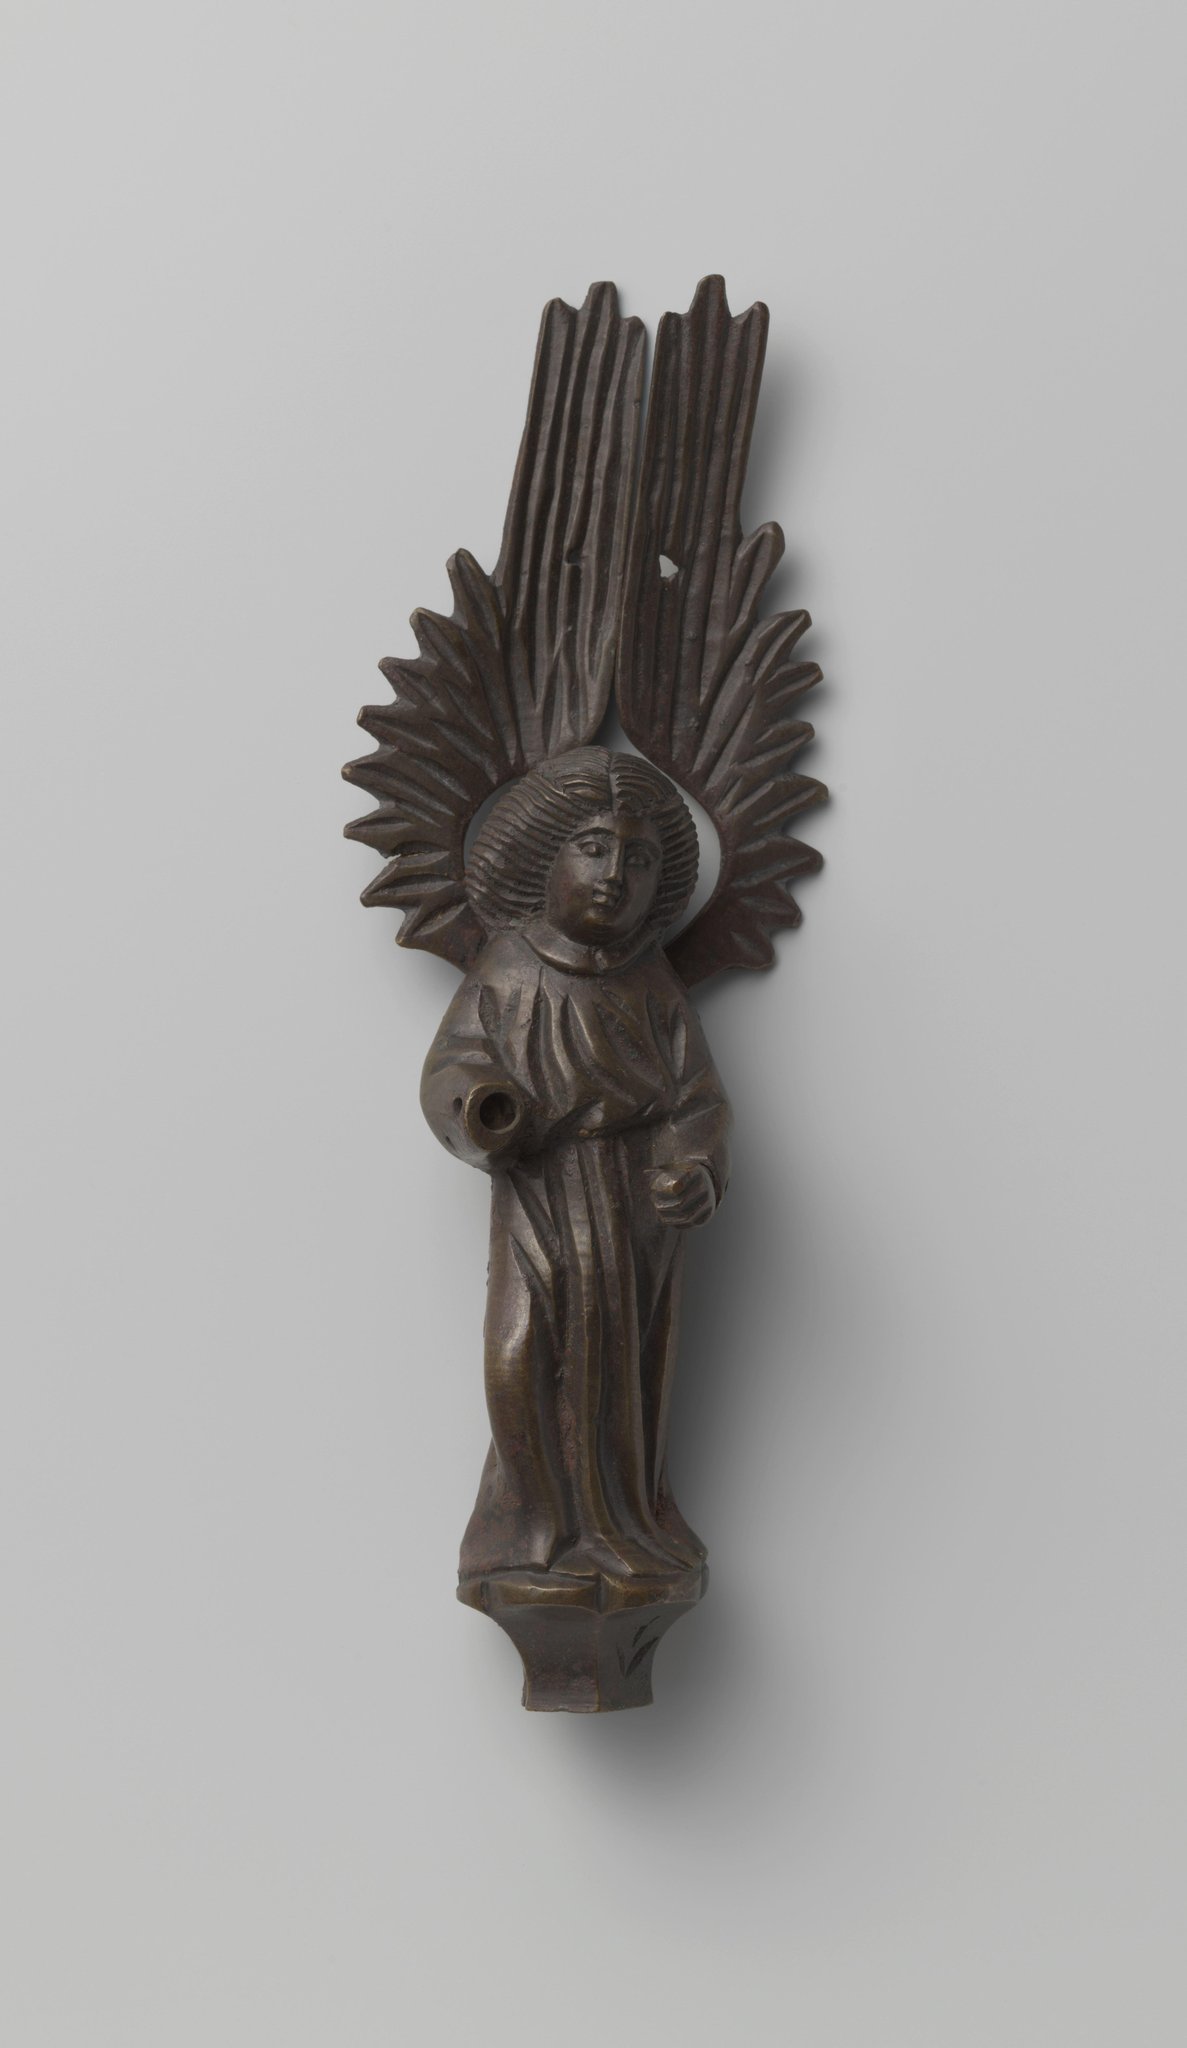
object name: figure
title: Engel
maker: Anonymous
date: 1475-1485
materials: brass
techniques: casting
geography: southern netherlands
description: De figuur bestaat uit de volgende gegoten, geciseleerde en getoken onderdelen: de engel, het vleugelstuk, de aan de linker arm geklonken hand. De engel staat op een vijfkantig voetstuk, dat vooraan is gemerkt, aan de achterkant een inkeping heeft en onderaan voorzien is van een schroefdraad voorzien rond gat. In de rug is een gedeelte uitgespaard om het oog, waarin met een pinnetje het vleugeldeel kan worden bevetstigd. De rechter hand en het voorwerp, dat de engel vasthield, ontbreken.